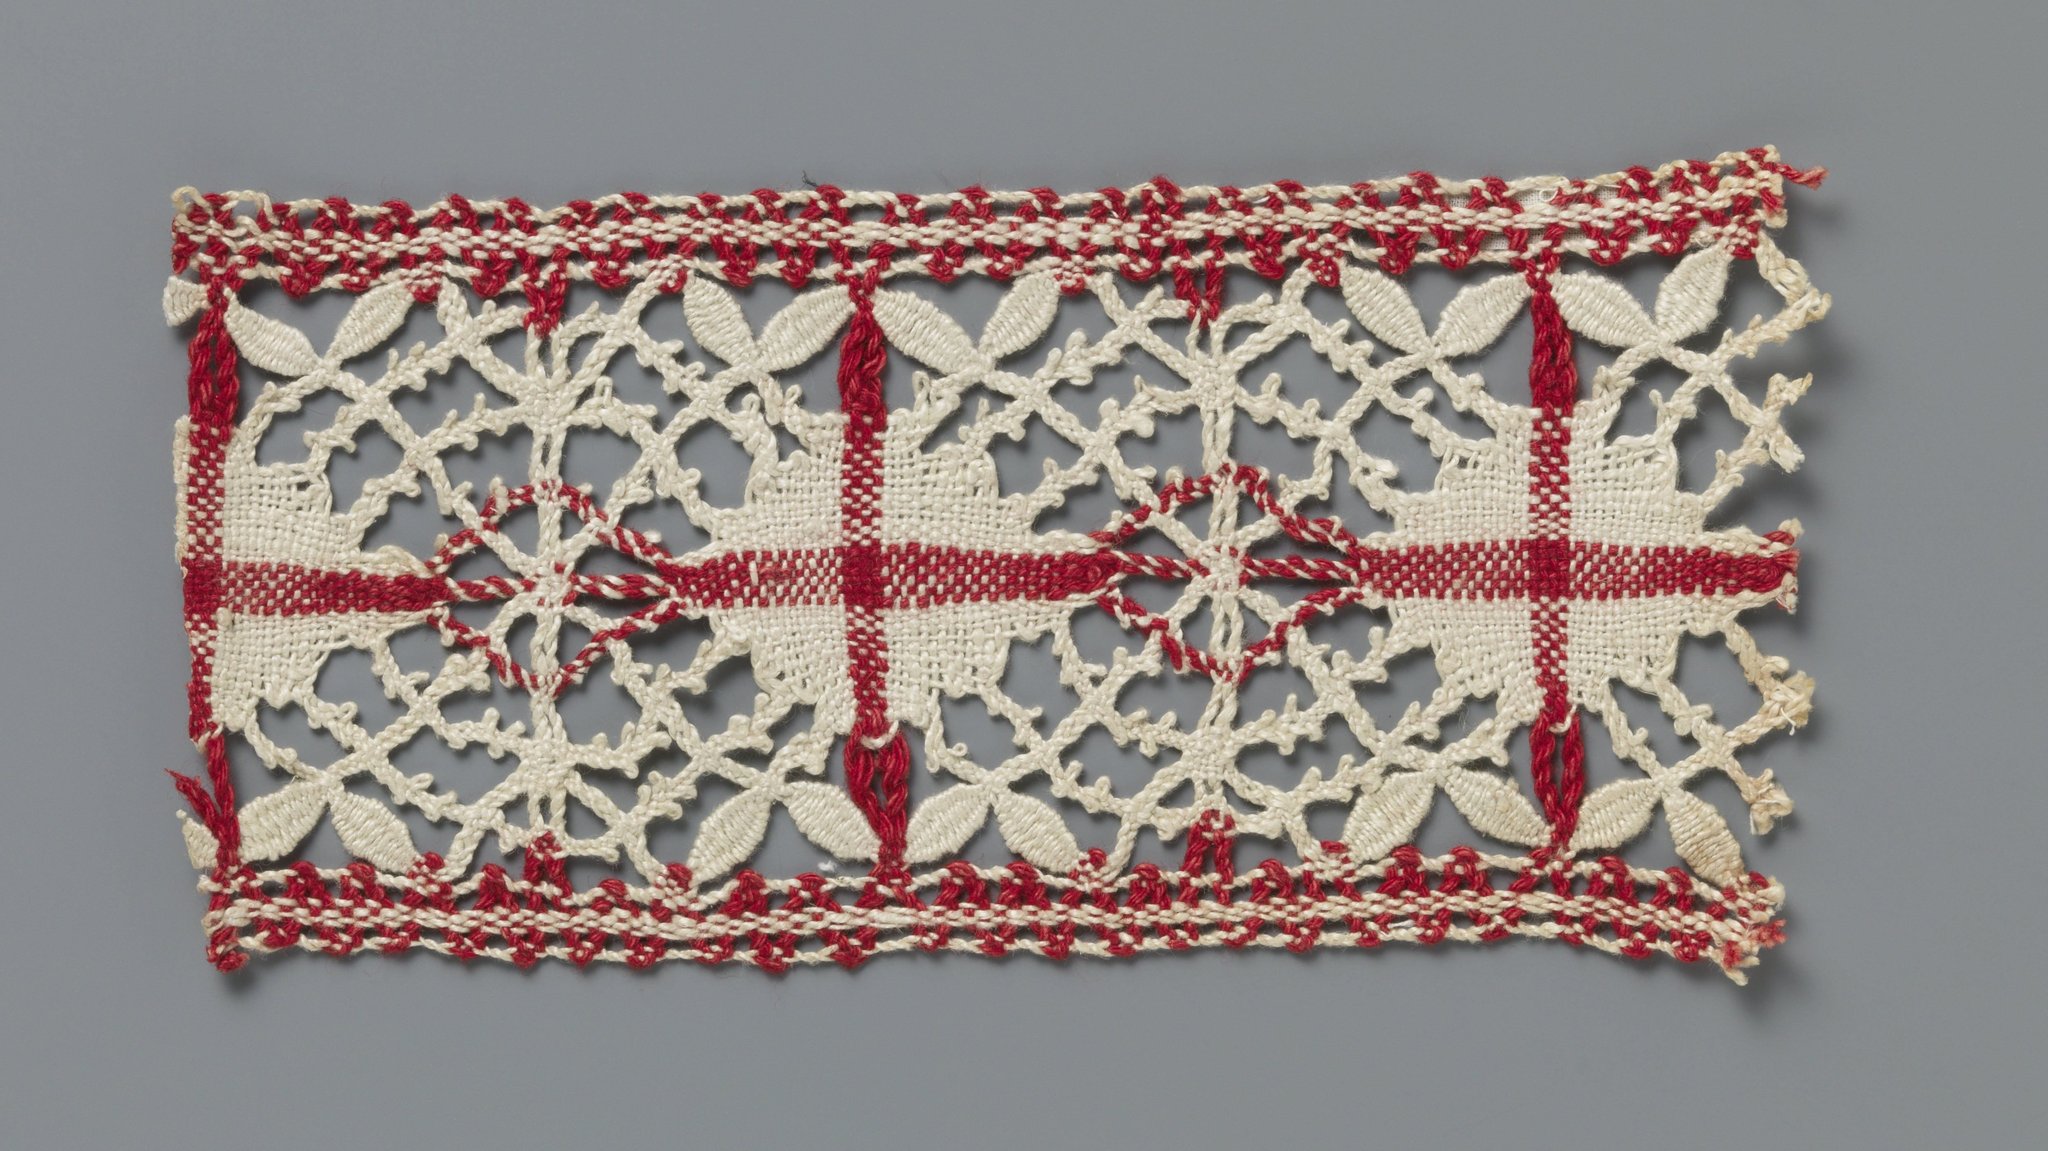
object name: entre deux, tussenzetsel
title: Tussenzetsel van rode en witte kloskant met concentrische cirkels in vierkante velden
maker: Anonymous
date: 1850-1899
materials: linen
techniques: lace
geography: bohemia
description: Tussenzetsel van gekleurde - rode en witte - kloskant: Cluny-kant. Het zich herhalende patroon bestaat uit een rij vierkante velden, gemarkeerd door rode lijnen. In elk veld vormen twee gepicoteerde vlechten concentrische cirkels om een rood-wit ruit in het centrum. In elke hoekpunt staan twee blaadjes gemaakt in vormslag. De rode ruit in het centrum van elk veld gaat over in een grotere witte ruit in linnenslag. Deze staat half in het ene veld en half in het volgende veld. De rode draden waarmee de velden gemarkeerd worden en waarmee de rode ruiten gevormd worden zorgen voor een rood kruis in de witte ruiten. Boven- en onderzijde zijn recht afgewerkt met een rode zigzag door horizontale witte draden.